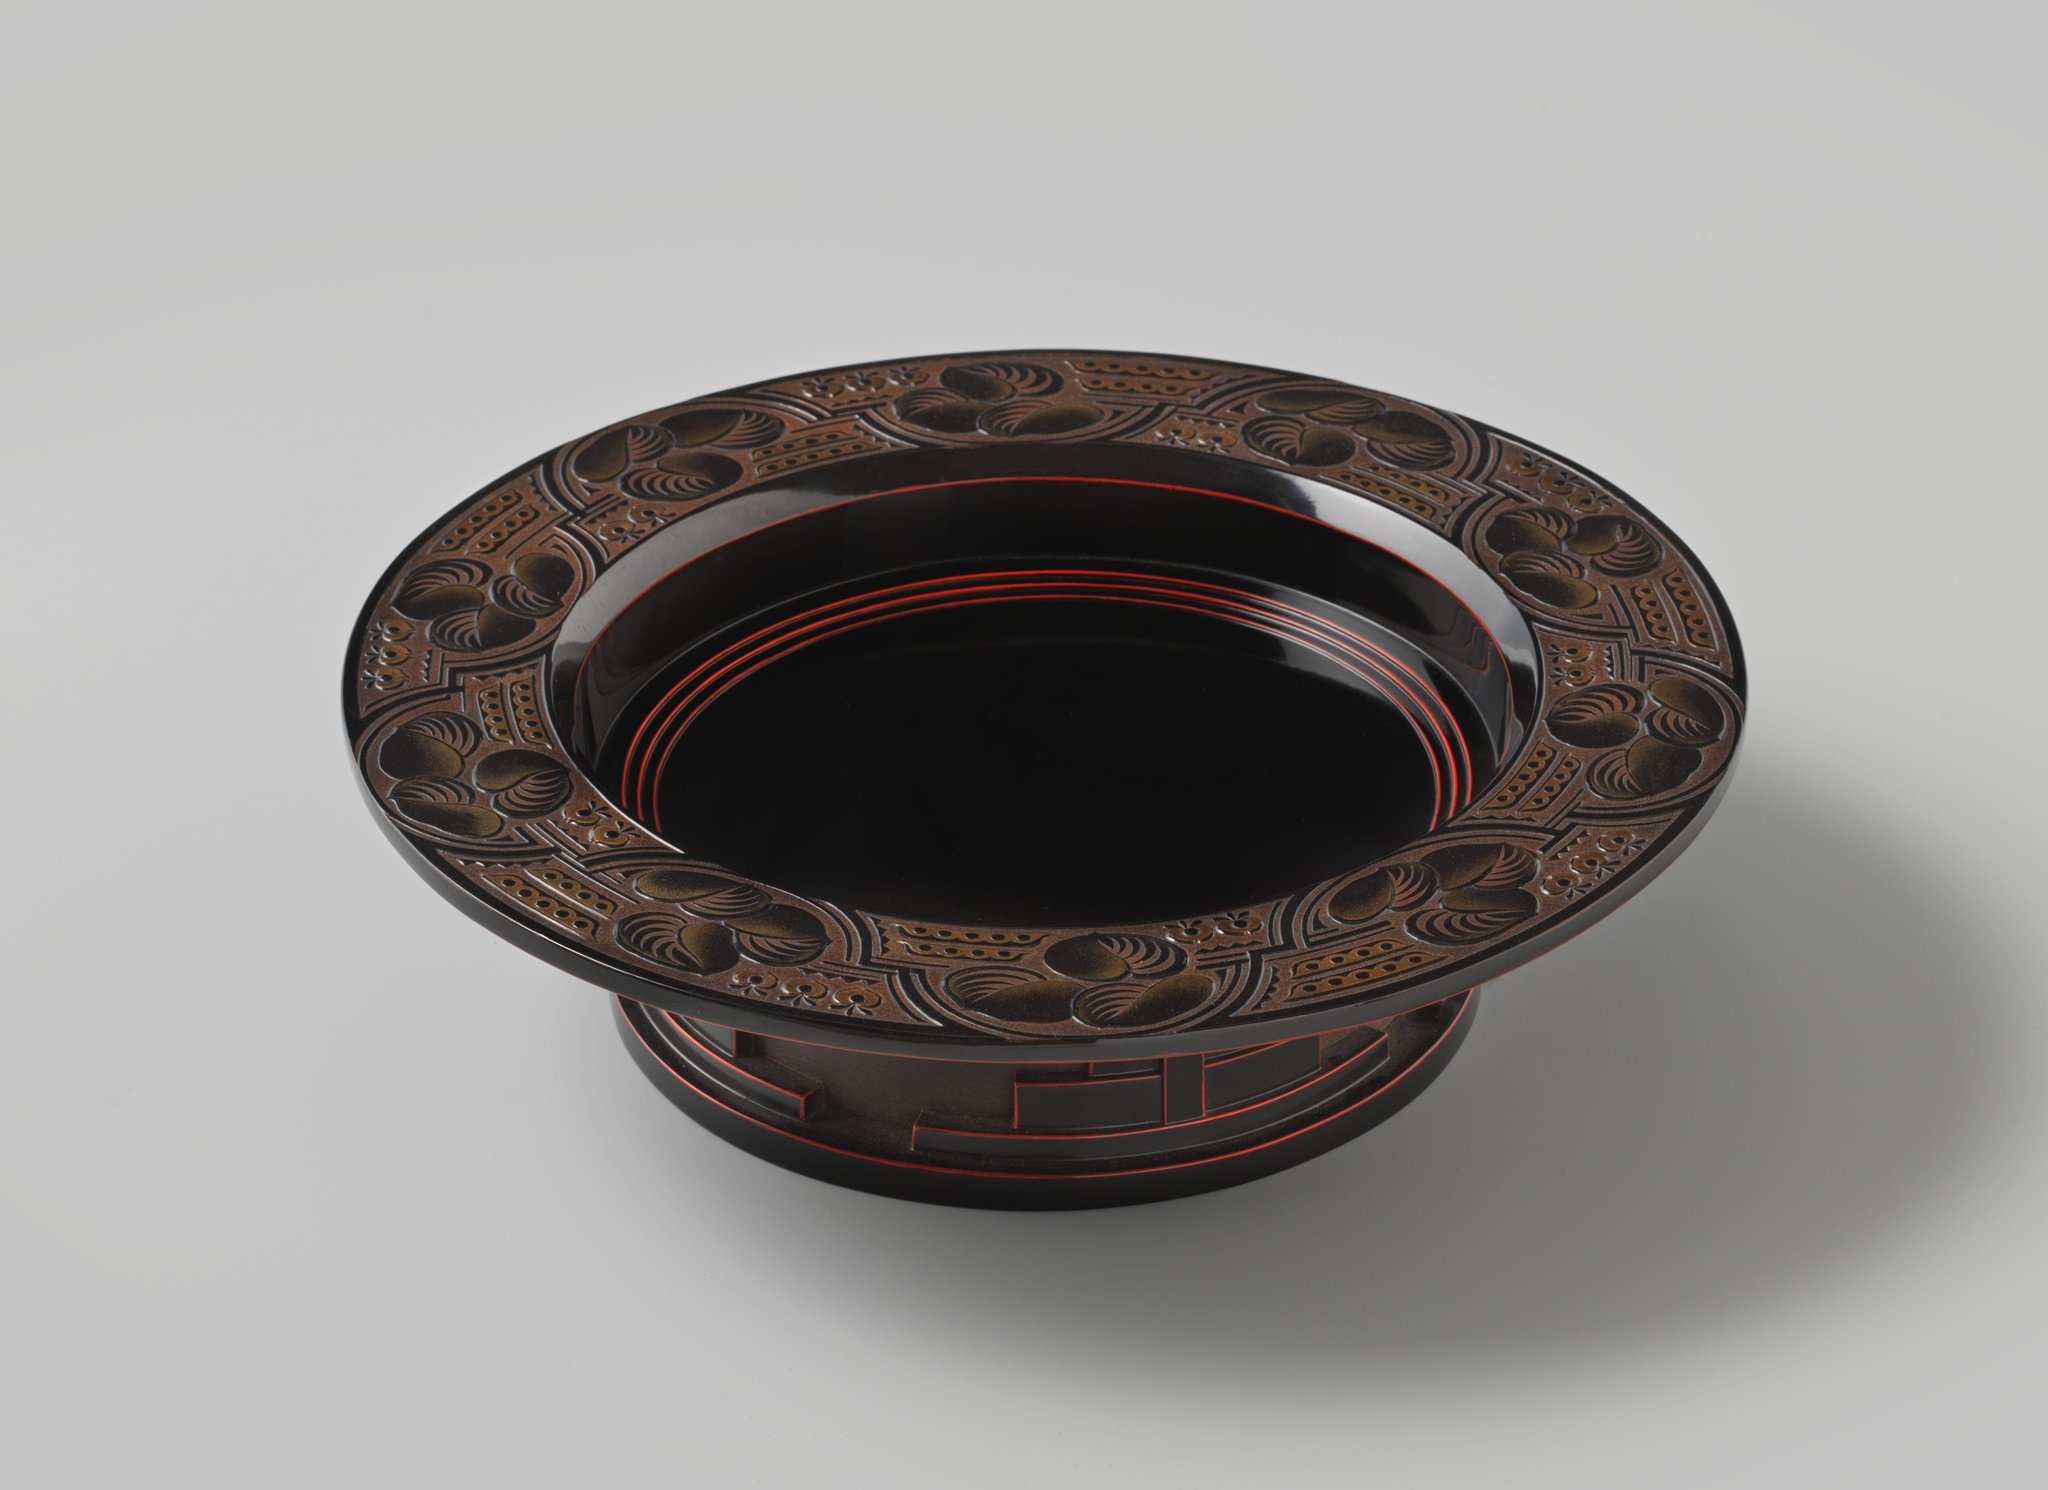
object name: fruit bowl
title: Circular tray on High Foot and Rim of Stylized Bean Pattern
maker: koshida bizan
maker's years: 1874-1941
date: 1930-1940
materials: lacquer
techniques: lacquer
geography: japan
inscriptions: seal: ‘a work of Bizan’, inscription: ‘Bizan saku’, inscription: ‘Moriki mame moyō’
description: The modernity of the 1920s and 1930s found individual expression all over the world. So too in Japan. The pattern of stylized beans on the edge of this dish evokes the Art Deco style. The geometric configuration of the base recalls the ancient supporting structure of Japanese temple roofs. The red lines emphasize the architectural form.